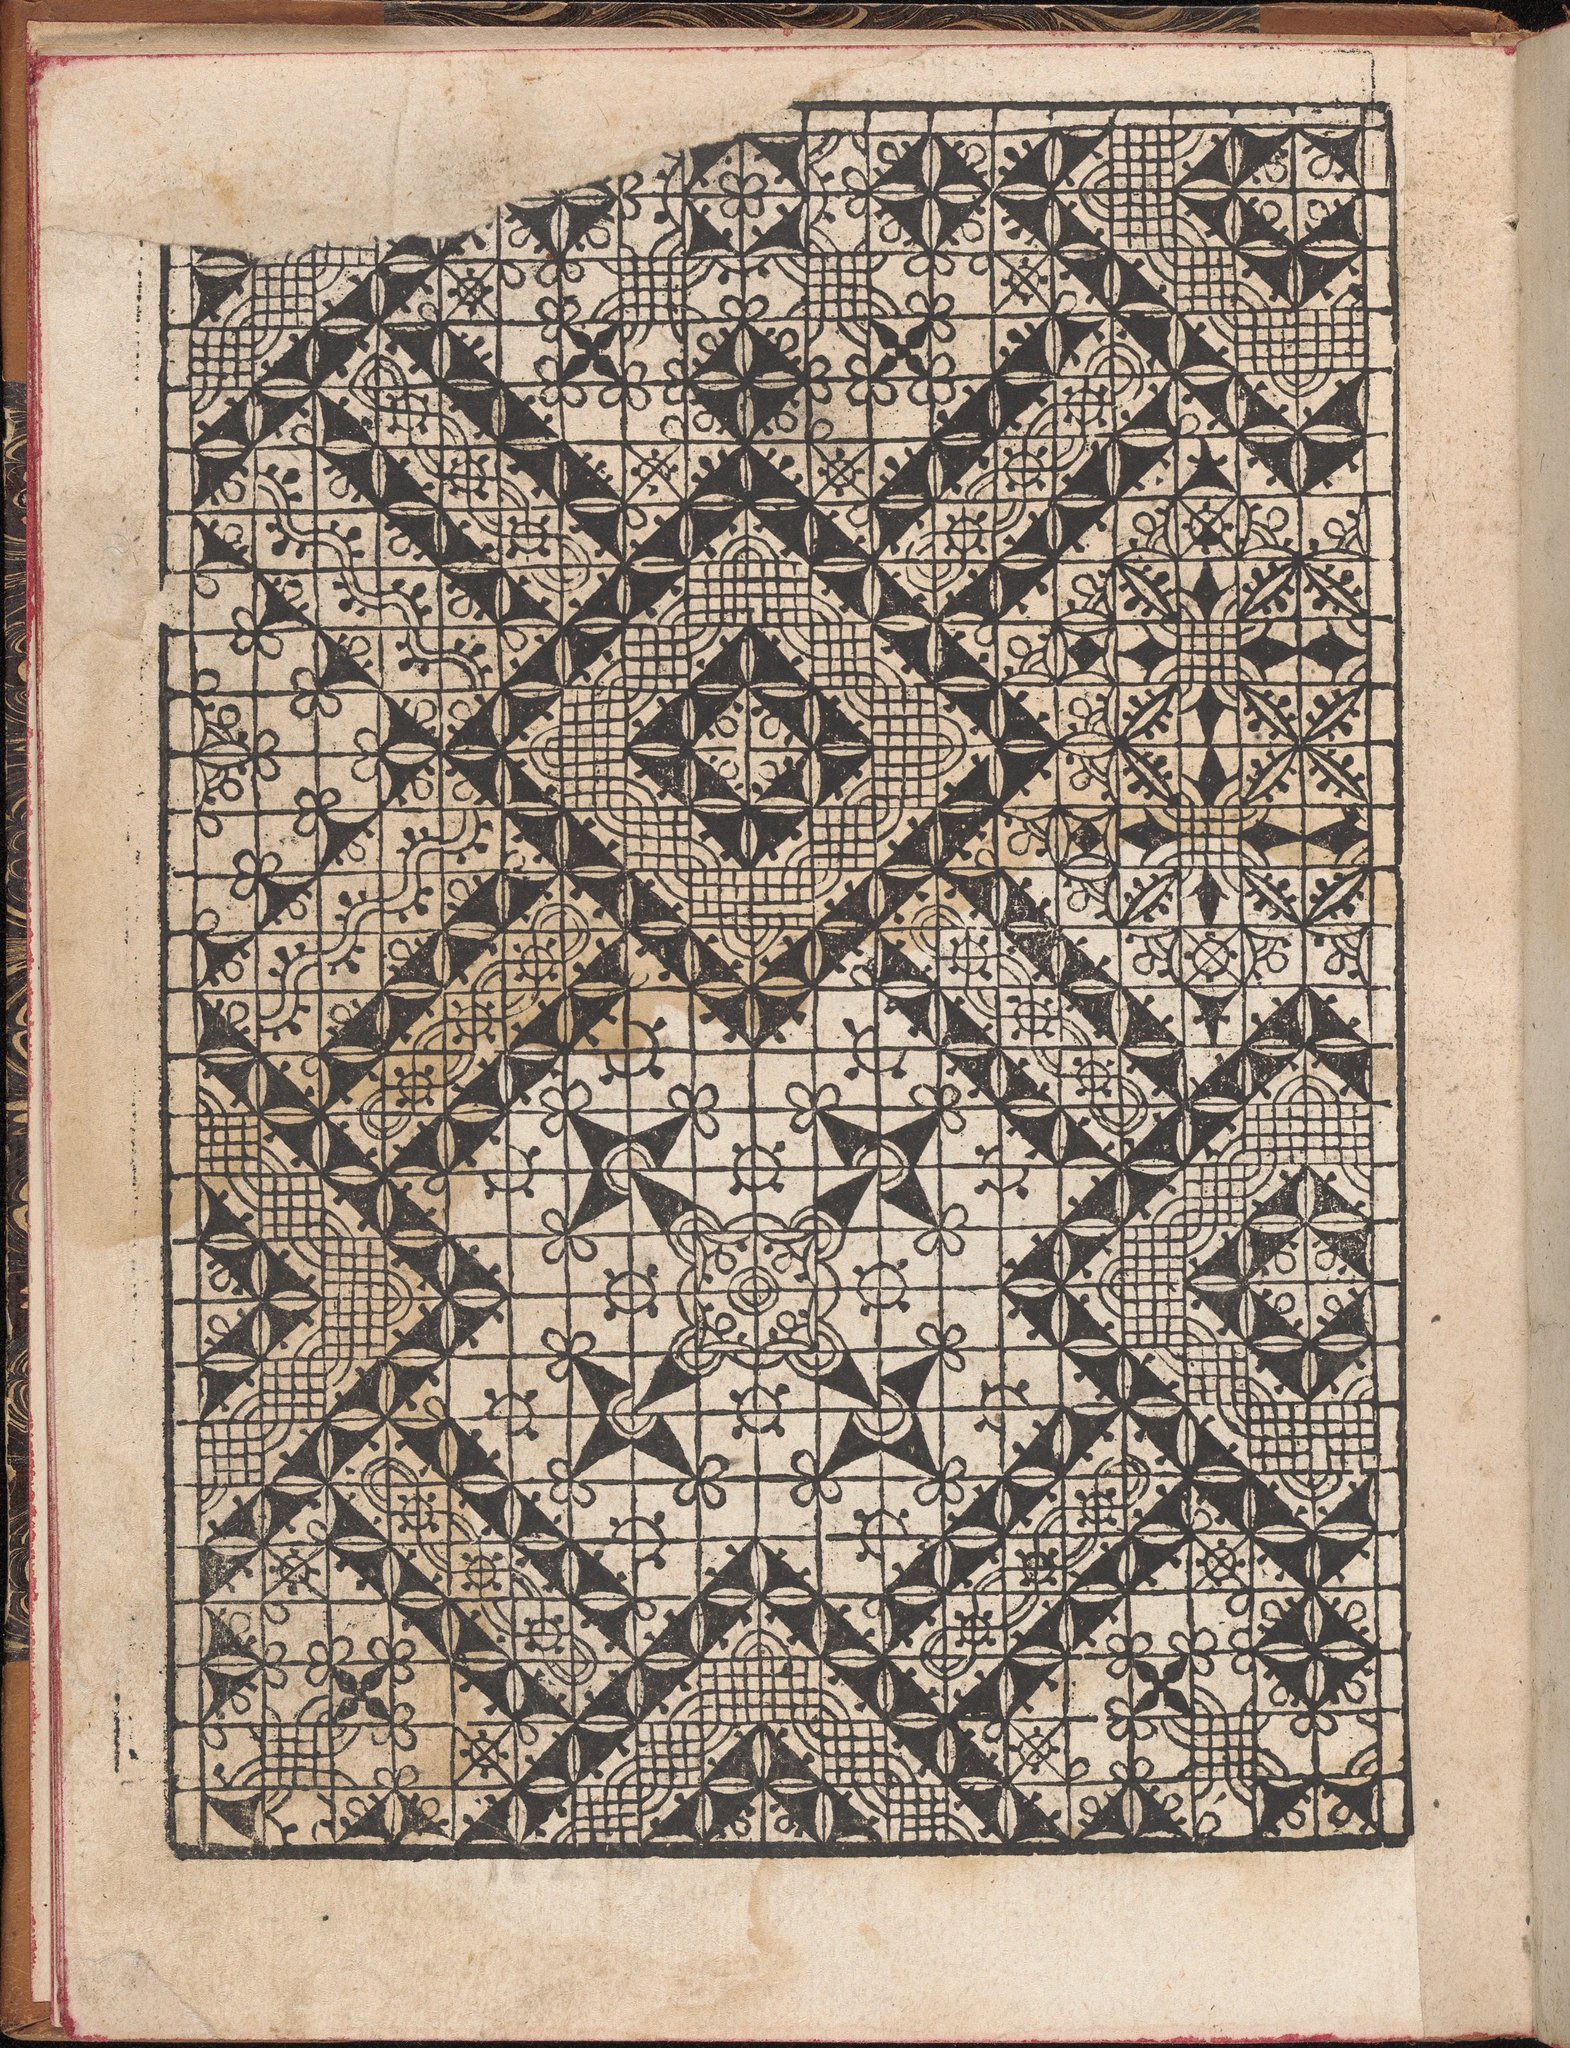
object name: book print ornament architecture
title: Spechio di pensieri delle belle et Virtudiose donne, page 3 (verso)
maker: matteo pagano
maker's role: publisher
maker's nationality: italian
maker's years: 1515-1588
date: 1546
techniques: woodcut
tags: ornament